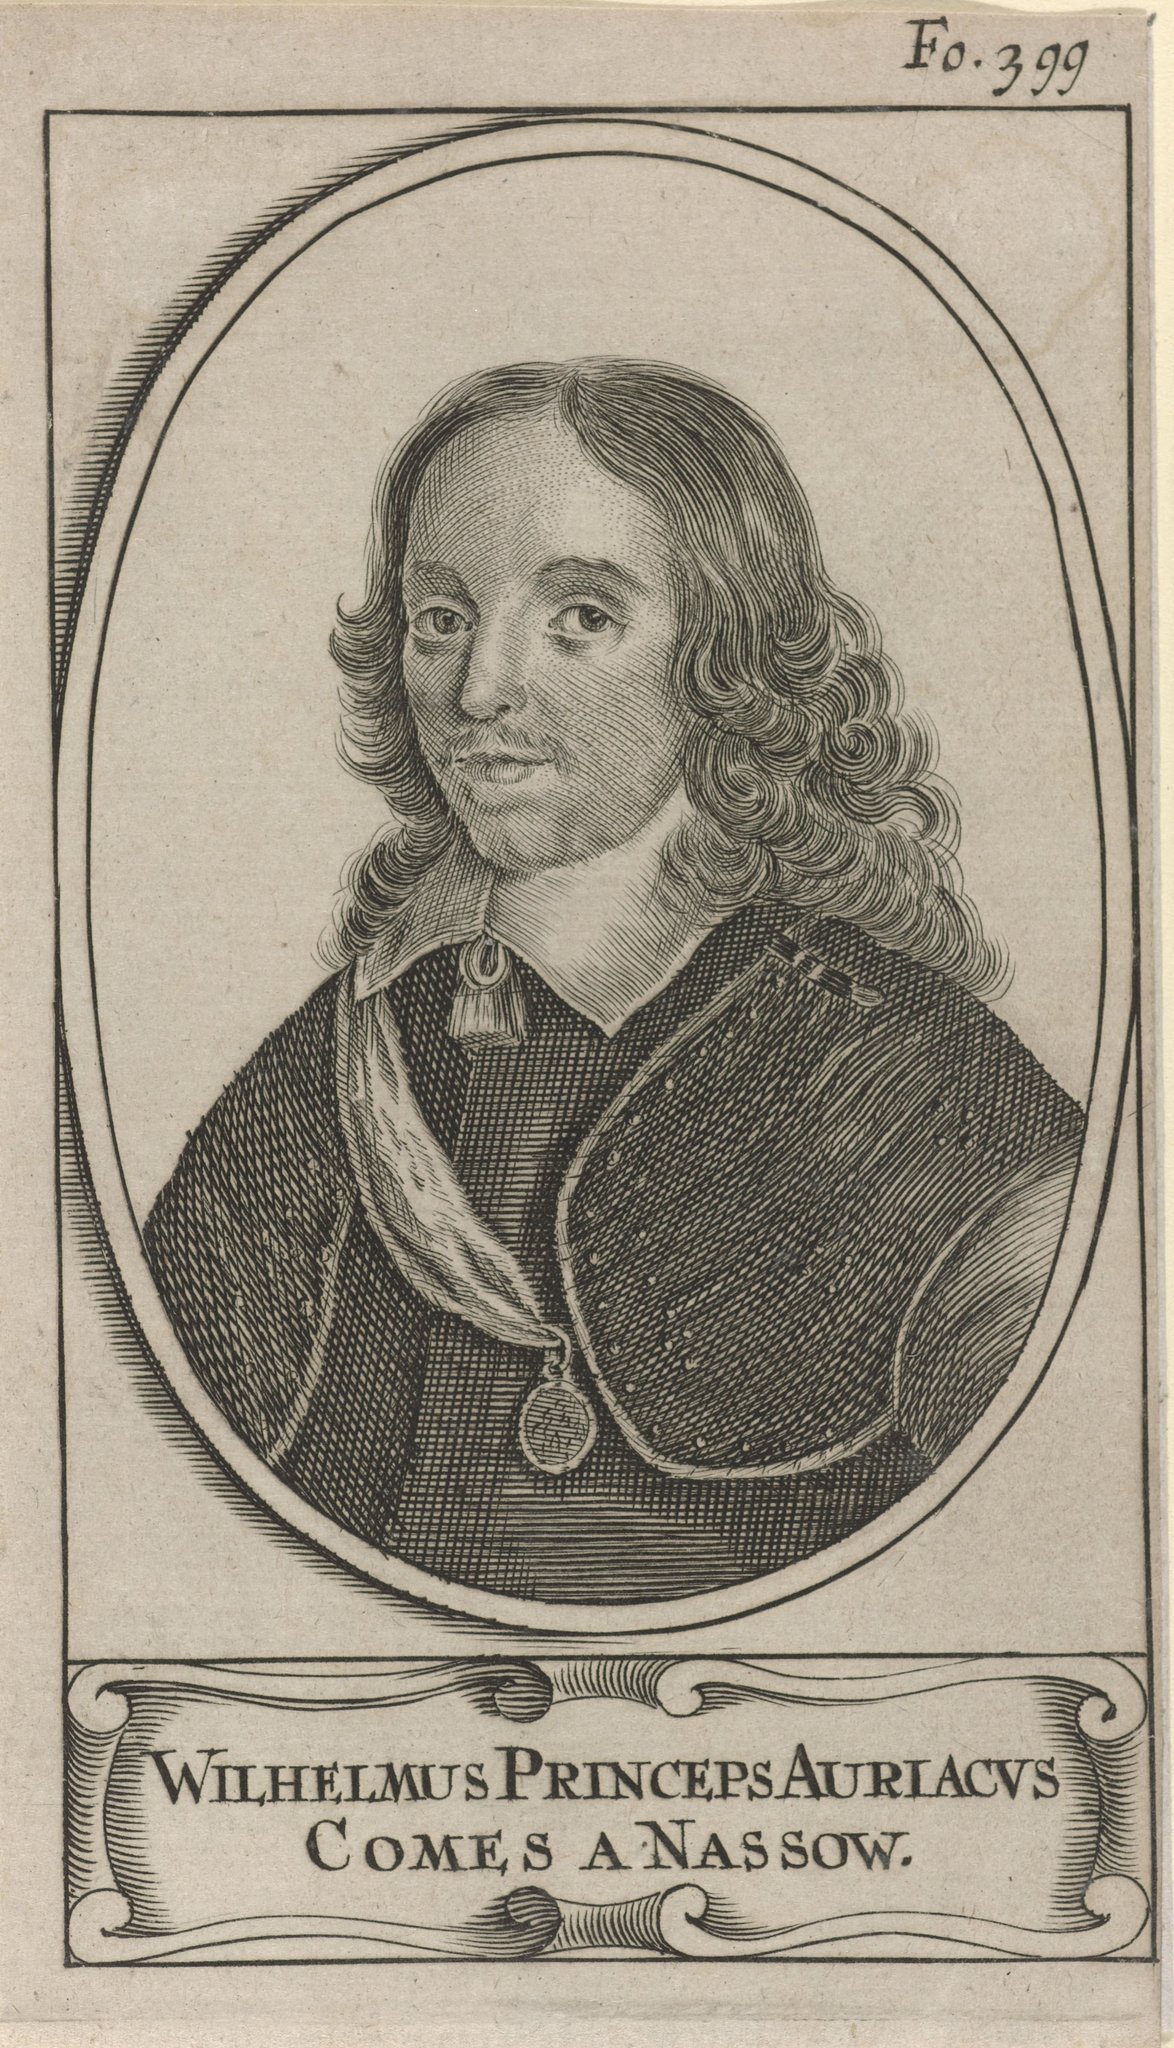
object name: print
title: Portret van Willem II, prins van Oranje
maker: Anonymous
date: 1650-1749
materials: paper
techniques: engraving, etching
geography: low countries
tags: william ii (prince of orange), knighthood order (garter) - insignia of a knighthood order, e.g.: badge, chain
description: De hier vermelde titel verwijst naar de hoogst verkregen titel van de geportretteerde, niet per se naar de titel die de geportretteerde op deze voorstelling draagt.